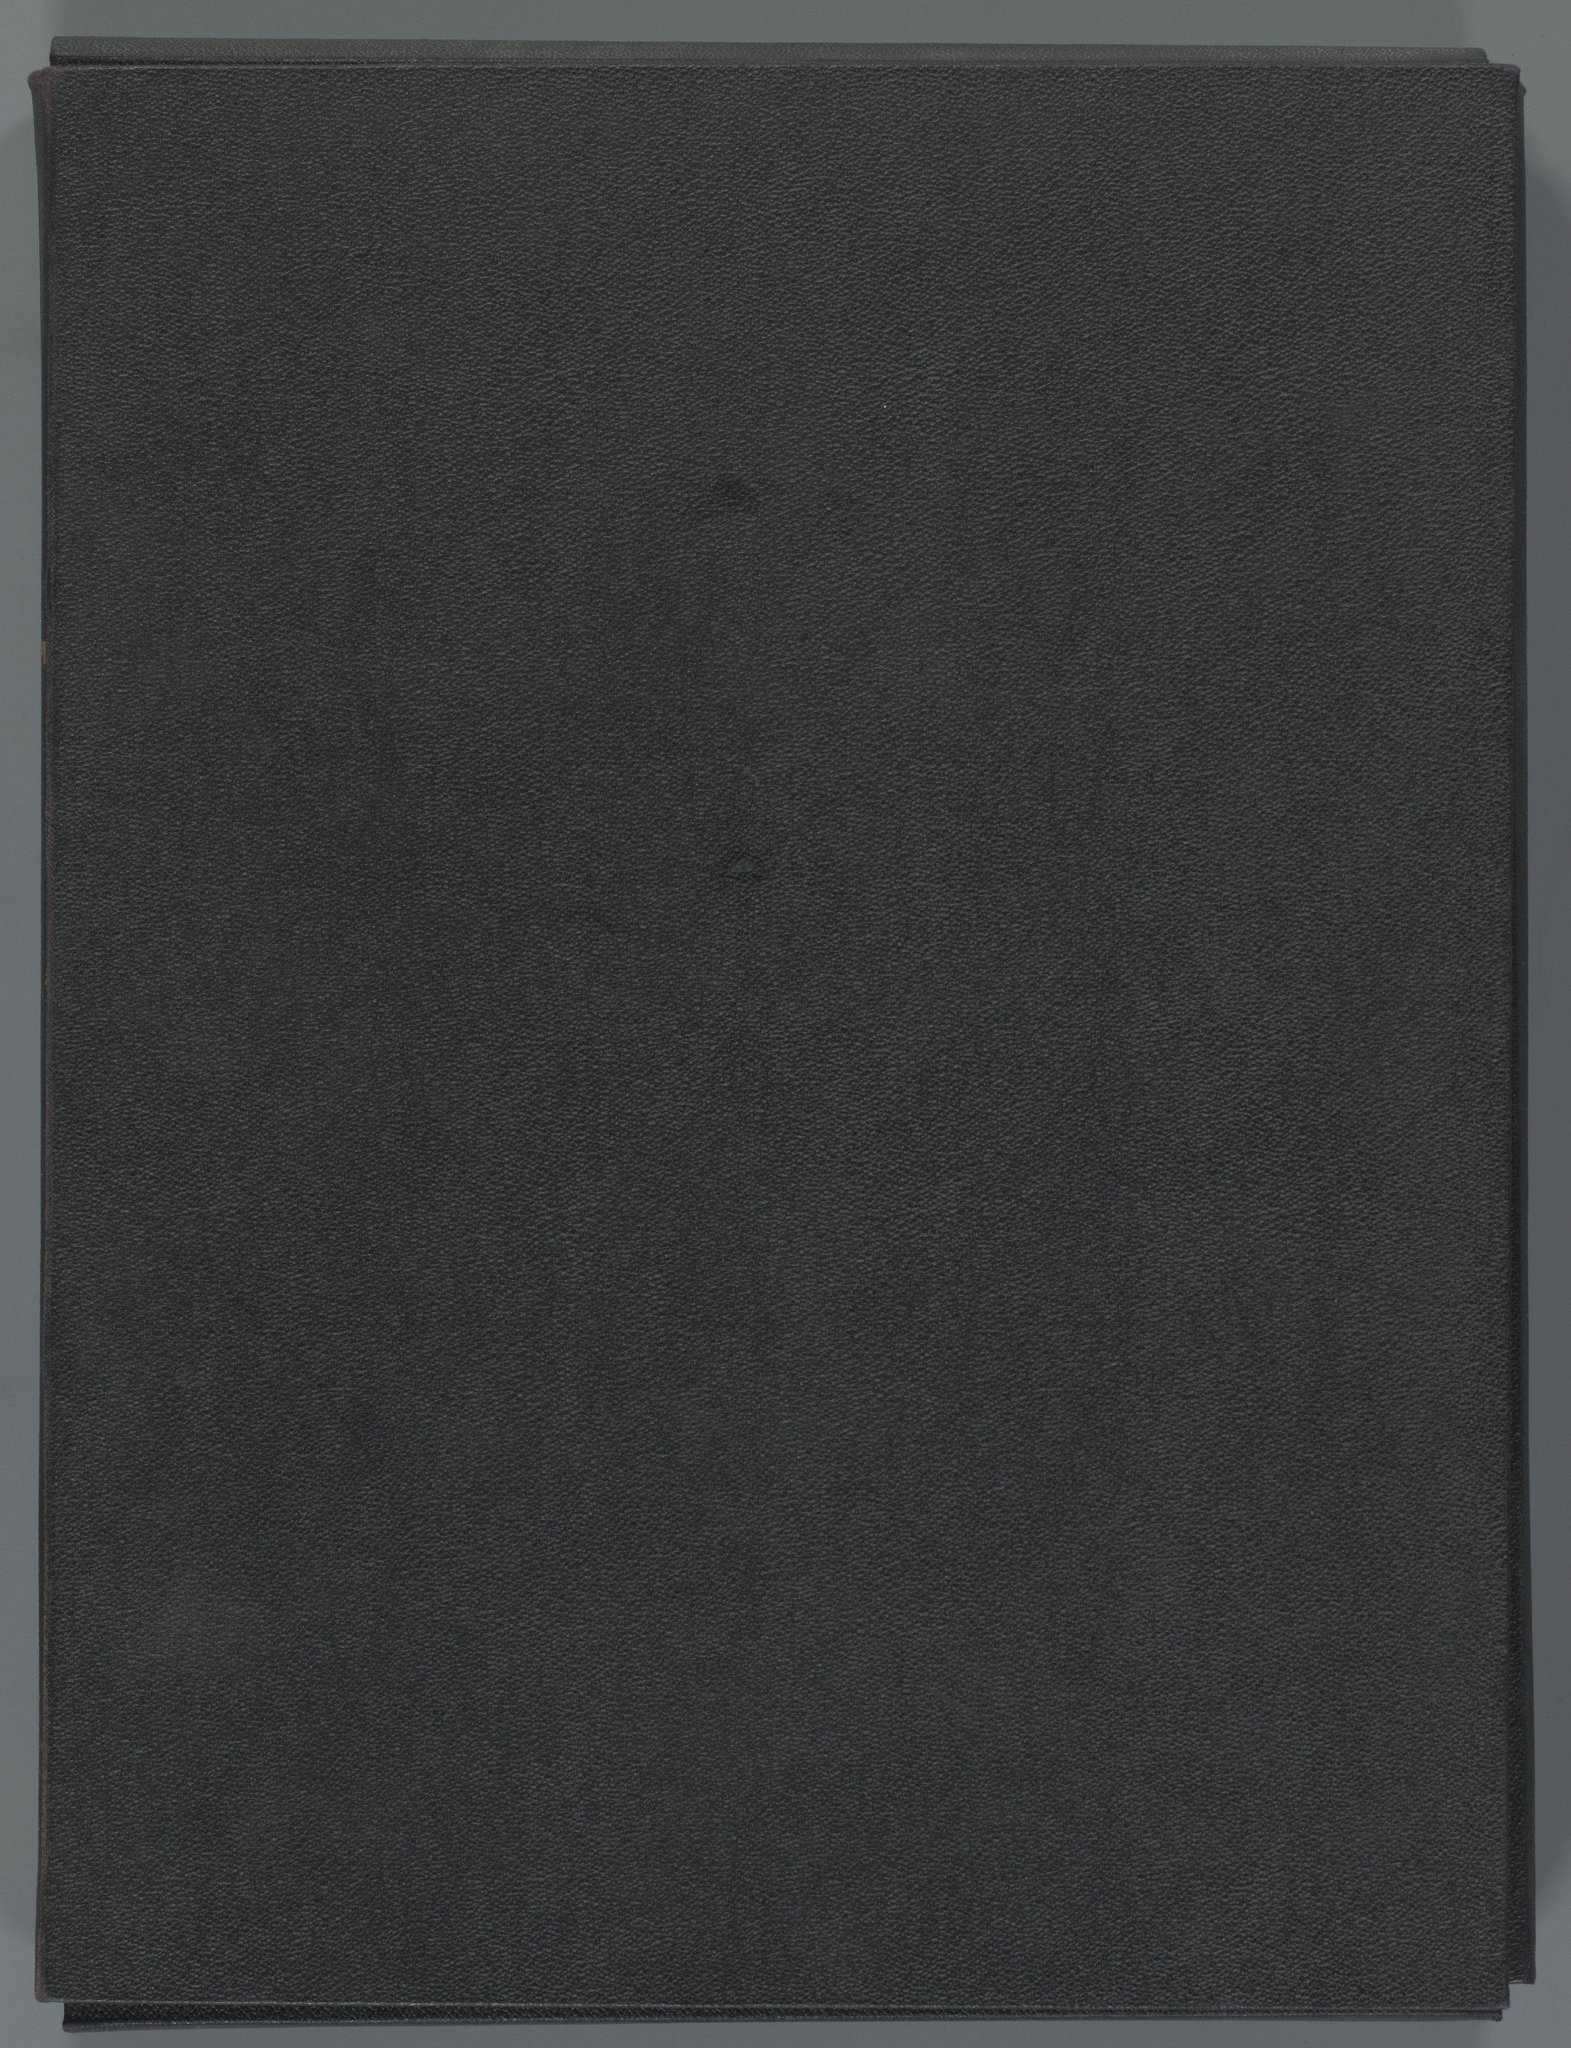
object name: wrapper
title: Beurs te Amsterdam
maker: Anonymous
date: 1903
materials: cardboard, linen, paper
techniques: gelatin silver print, retouching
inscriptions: inscription: ‘45 stuks/ aangeboden door J./ den Heer C. [doorgestreept] vander Linde/ Beursgebouw 1979’